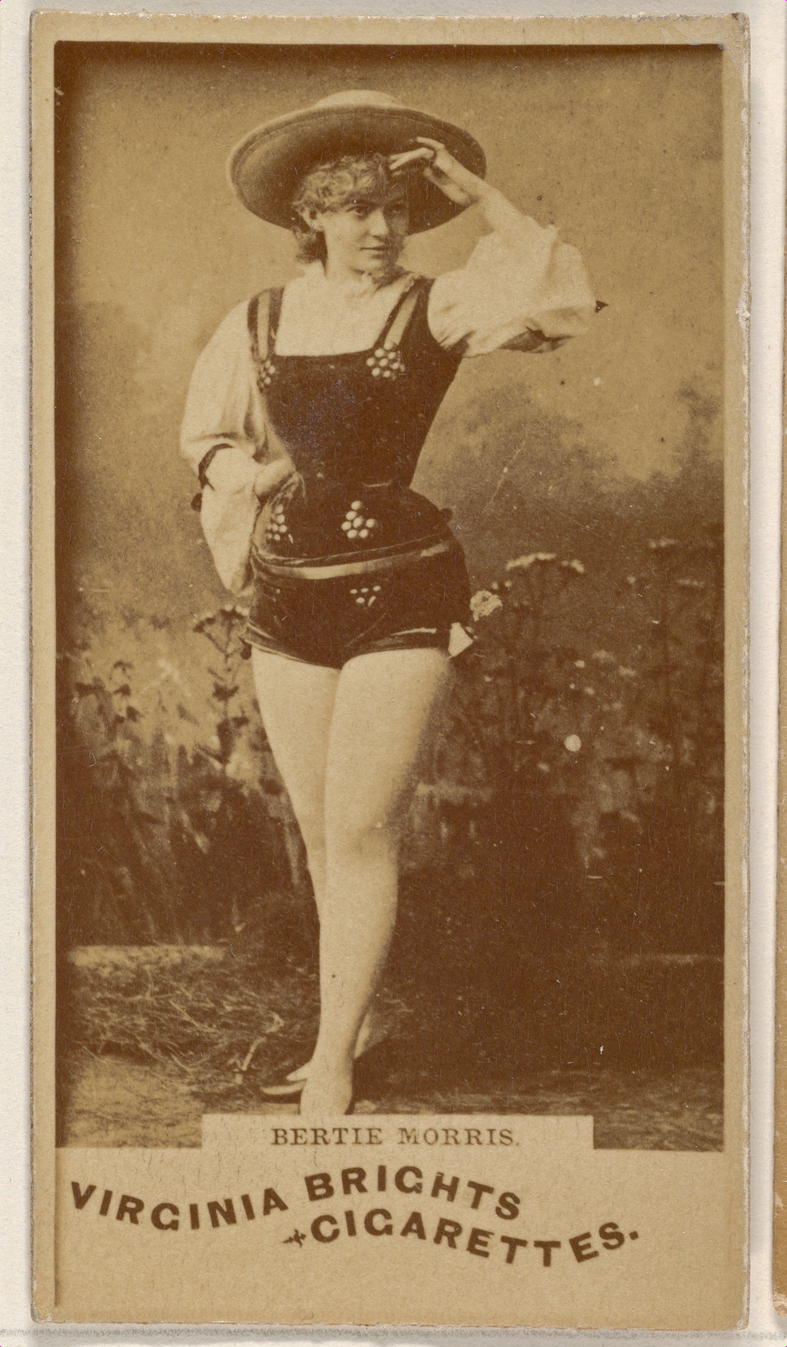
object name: photograph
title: Bertie Morris, from the Actors and Actresses series (N45, Type 1) for Virginia Brights Cigarettes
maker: allen & ginter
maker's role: publisher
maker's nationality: american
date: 1888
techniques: albumen silver print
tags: portraits,women,actresses